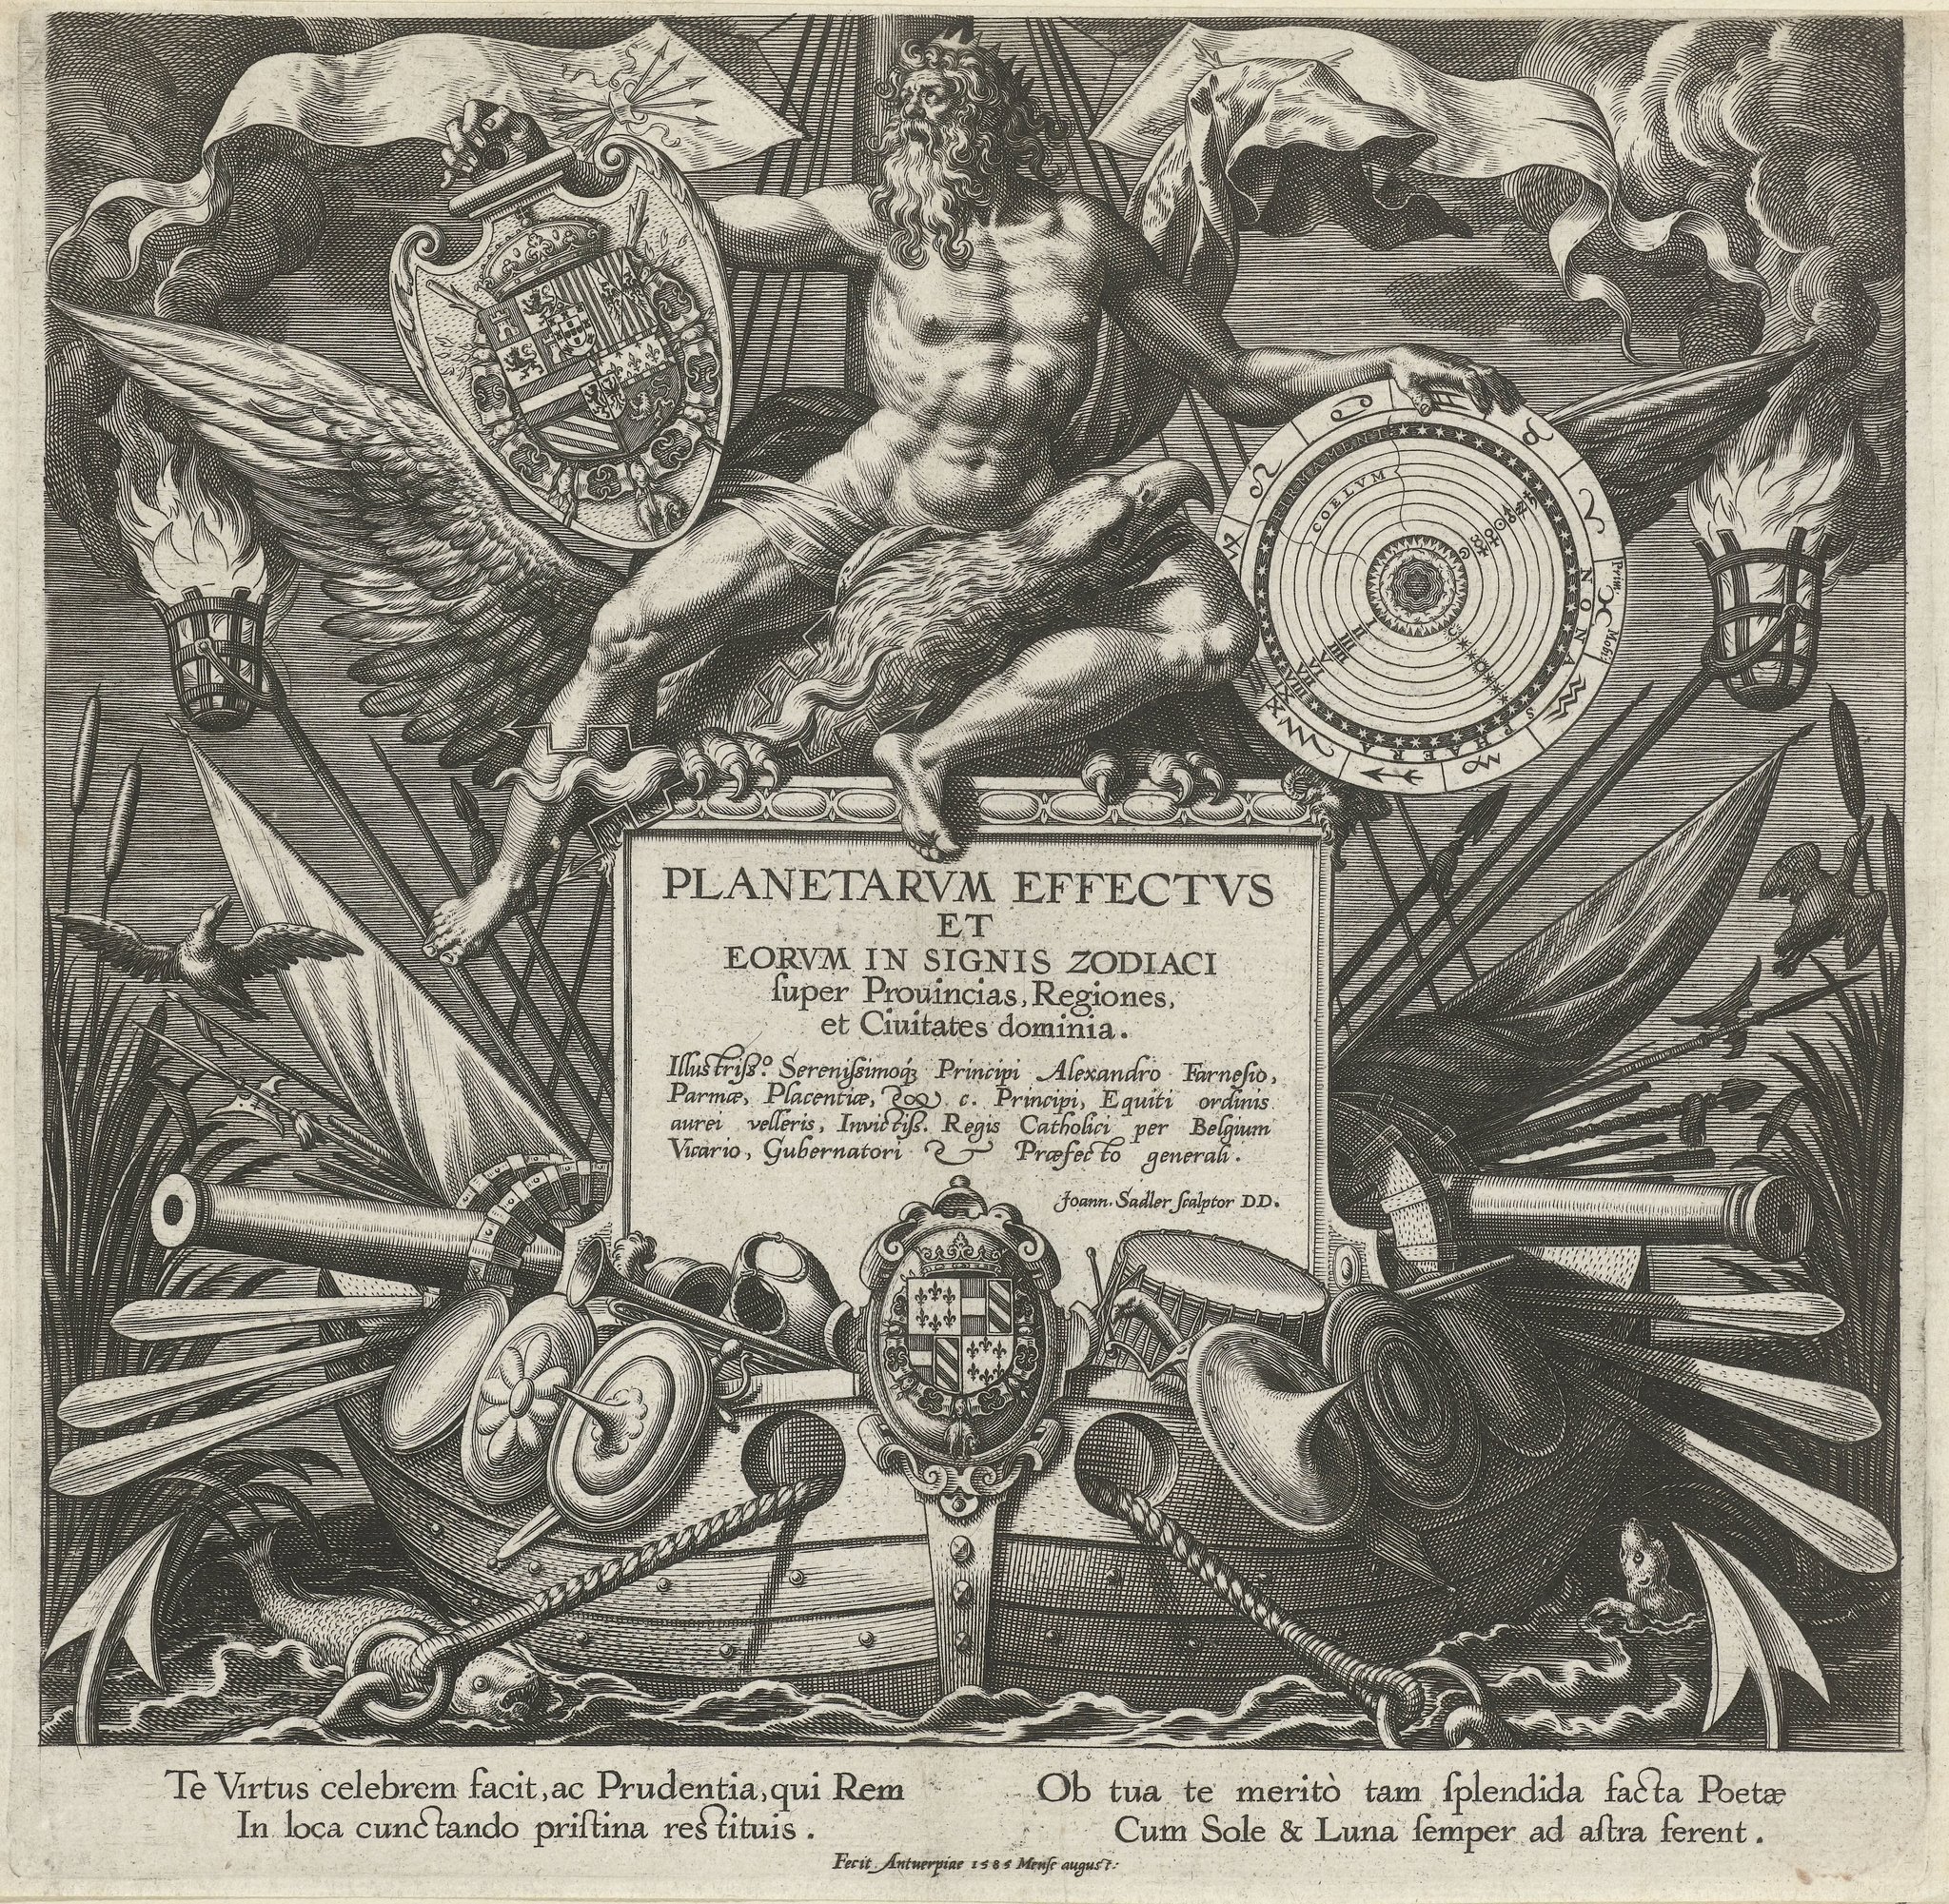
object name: print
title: Planetarvm effectvs et eorvm in signis zodiaci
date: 1585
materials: paper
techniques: engraving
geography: antwerp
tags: philip ii of spain, rome, alessandro farnese (landvoogd van de nederlanden en hertog van parma en piacenza), mankind influenced by the planets, including sun and moon; 'planetenkinder', (story of) jupiter (zeus), title-page, ships (in general), firearms: cannon, star-chart, star map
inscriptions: collector's mark: Lugt 240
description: Een oorlogsschip, versierd met de wapens van Alessandro Farnese. Op de boot een sokkel met de titel van de prentserie. Op de sokkel zit Jupiter met zijn adelaar, het wapenschild van Filips II en een hemelkaart in de handen. De titelprent van een prentserie over de invloed van de planeten over streken. In de marge een Latijns lofdicht.